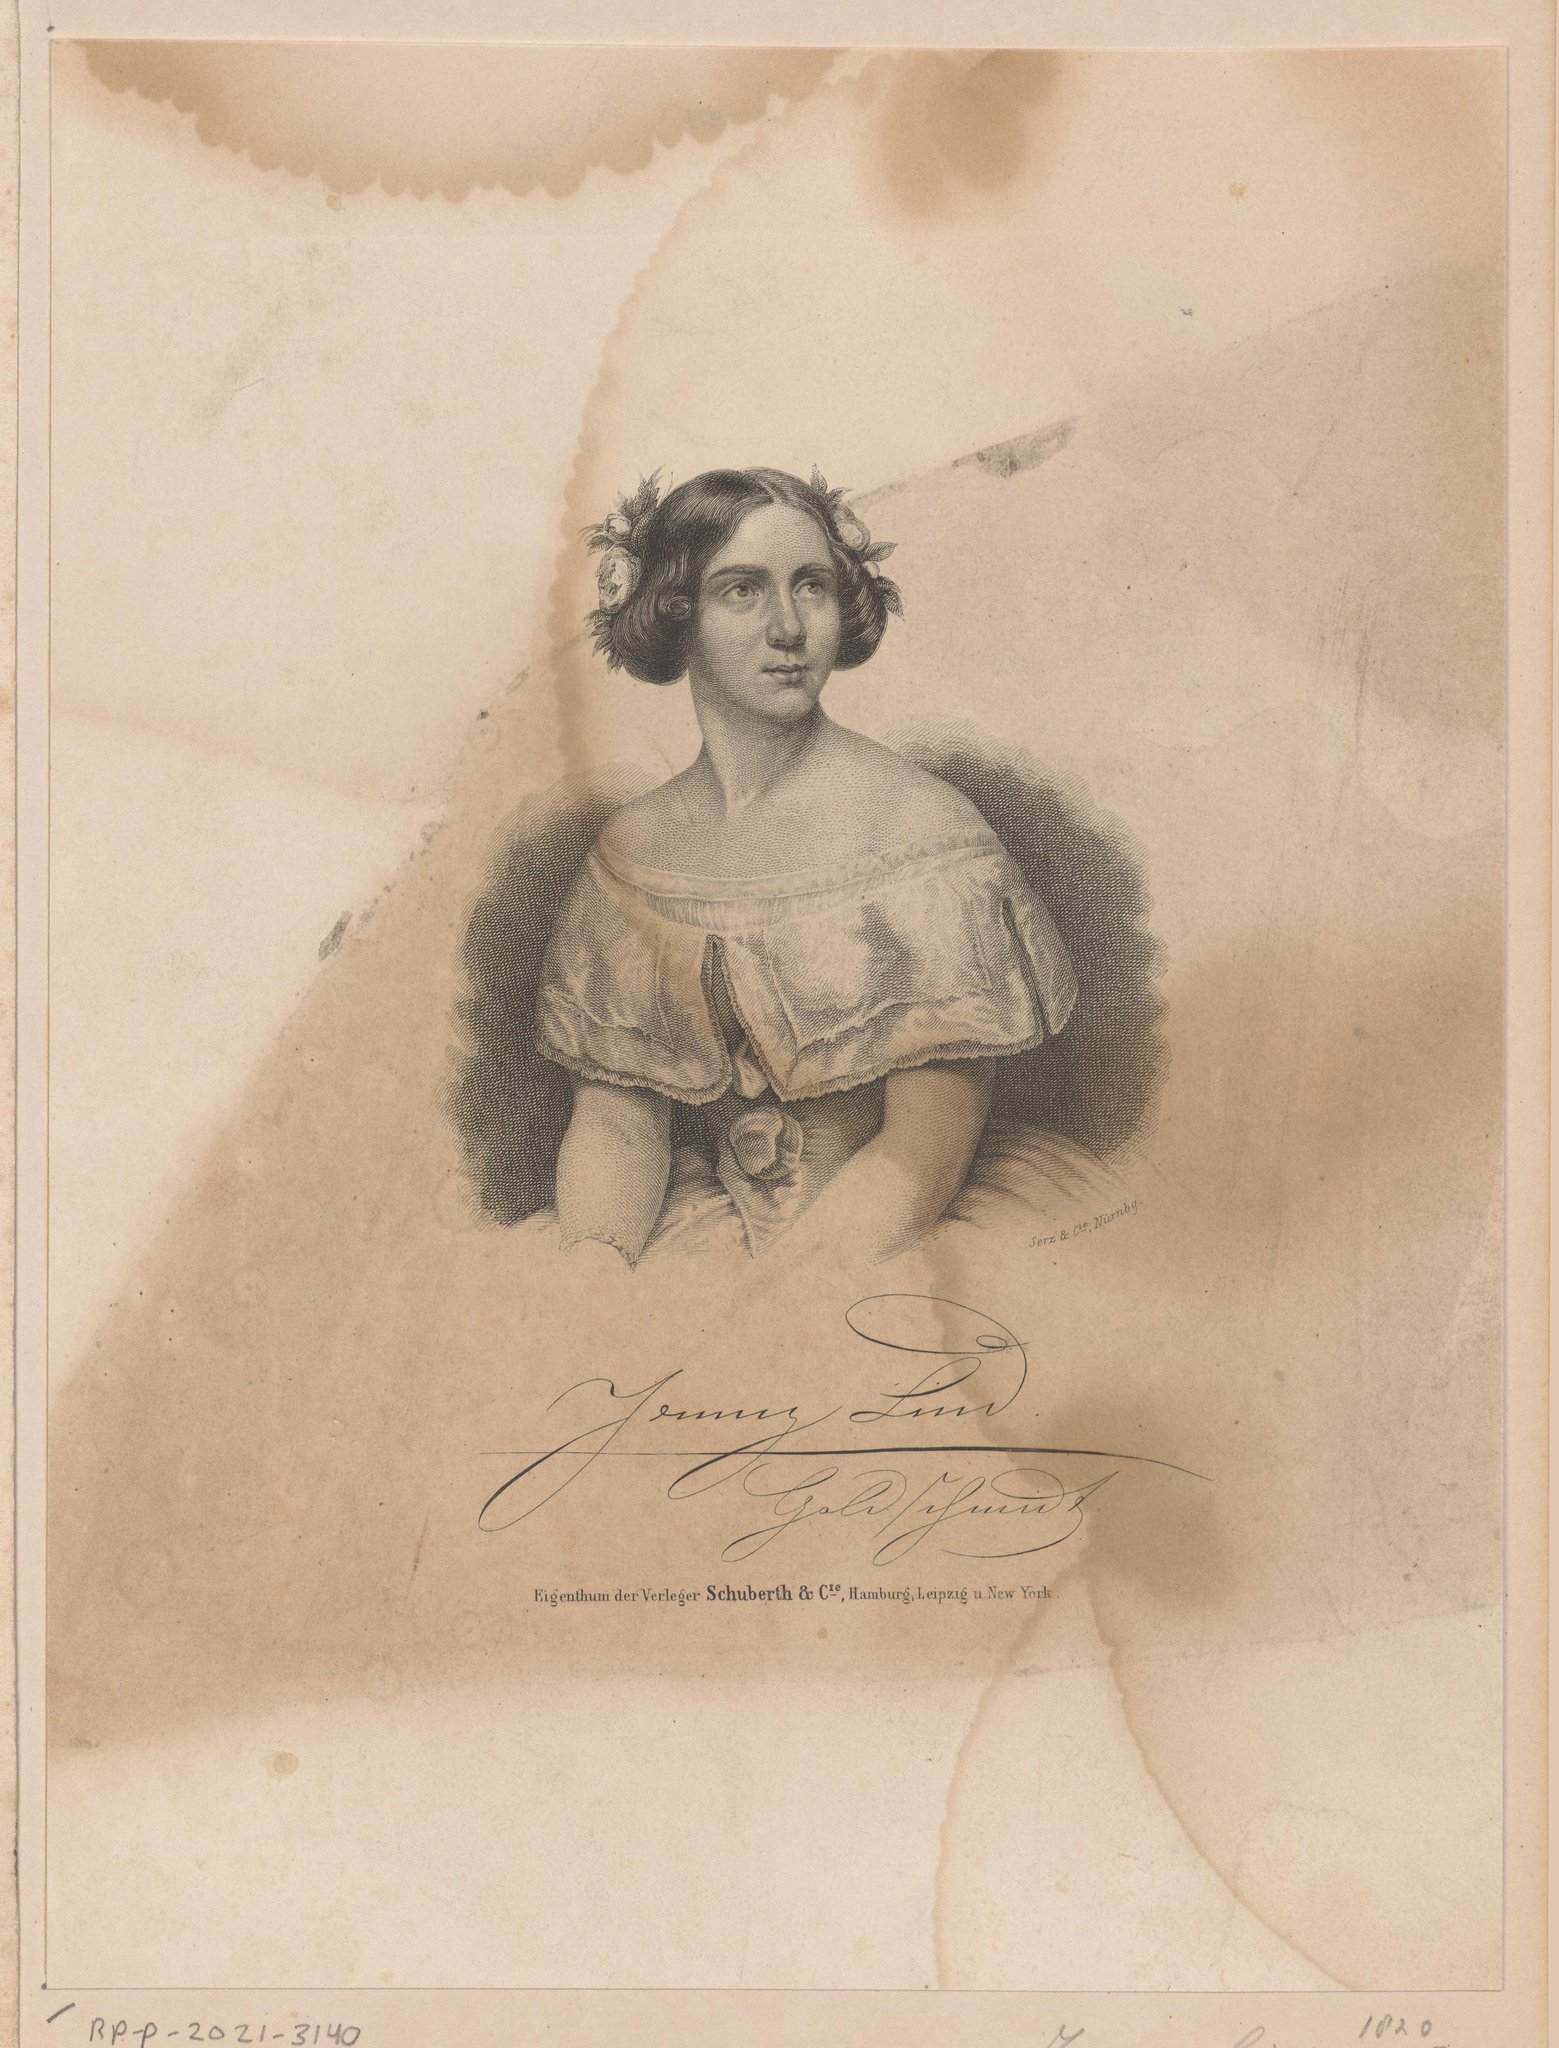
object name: print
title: Portret van Jenny Lind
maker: Anonymous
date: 1852-1878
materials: paper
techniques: etching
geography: germany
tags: historical persons - bb - woman, portrait of opera-singer